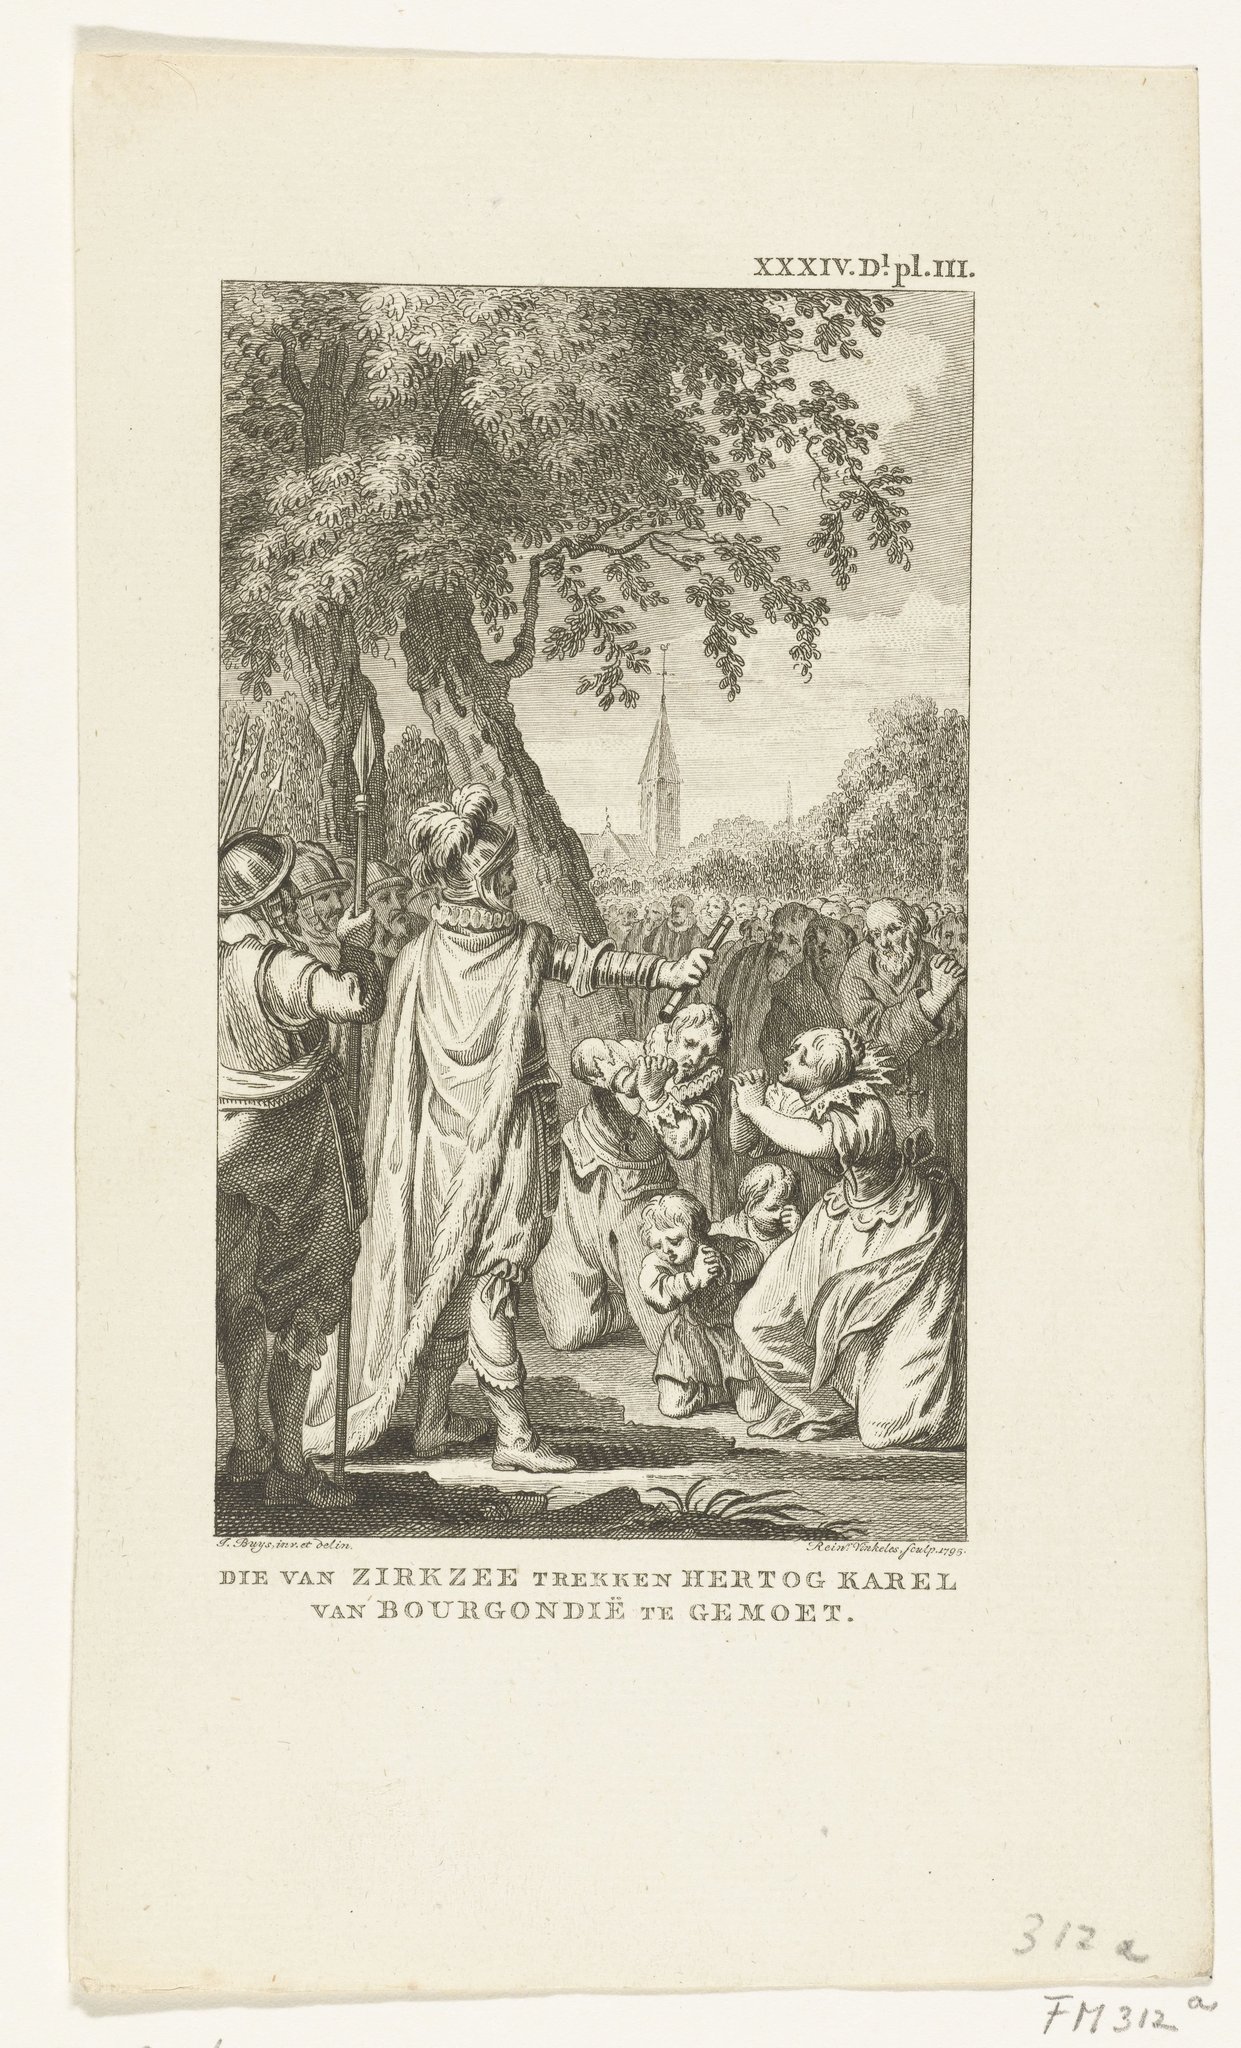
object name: print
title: Die van Zirkzee trekken hertog Karel van Bourgondië te gemoet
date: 1795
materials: paper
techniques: etching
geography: netherlands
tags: earl, charles the bold (duke of burgundy), burgundian netherlands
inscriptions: date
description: Illustratie voor: Jacobus Kok, Vaderlandsch Woordenboek, Johannes Allart, Amsterdam 1785-1799, 35 delen, dl. XXXIV, pl. III. Staat met de letter.